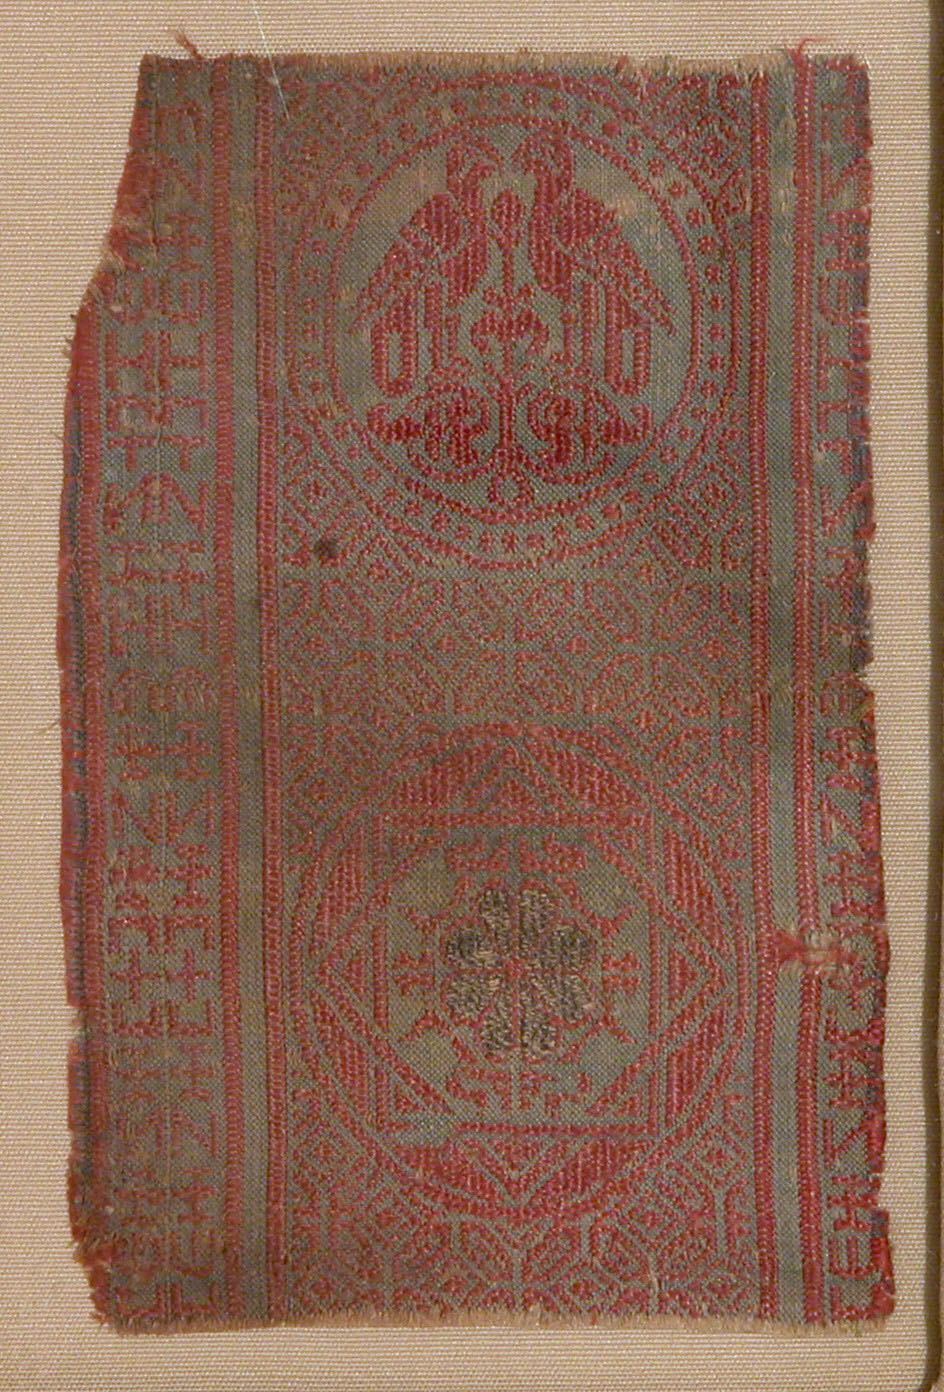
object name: textile fragment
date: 1201-1300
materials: metal thread, silk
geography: spain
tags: birds